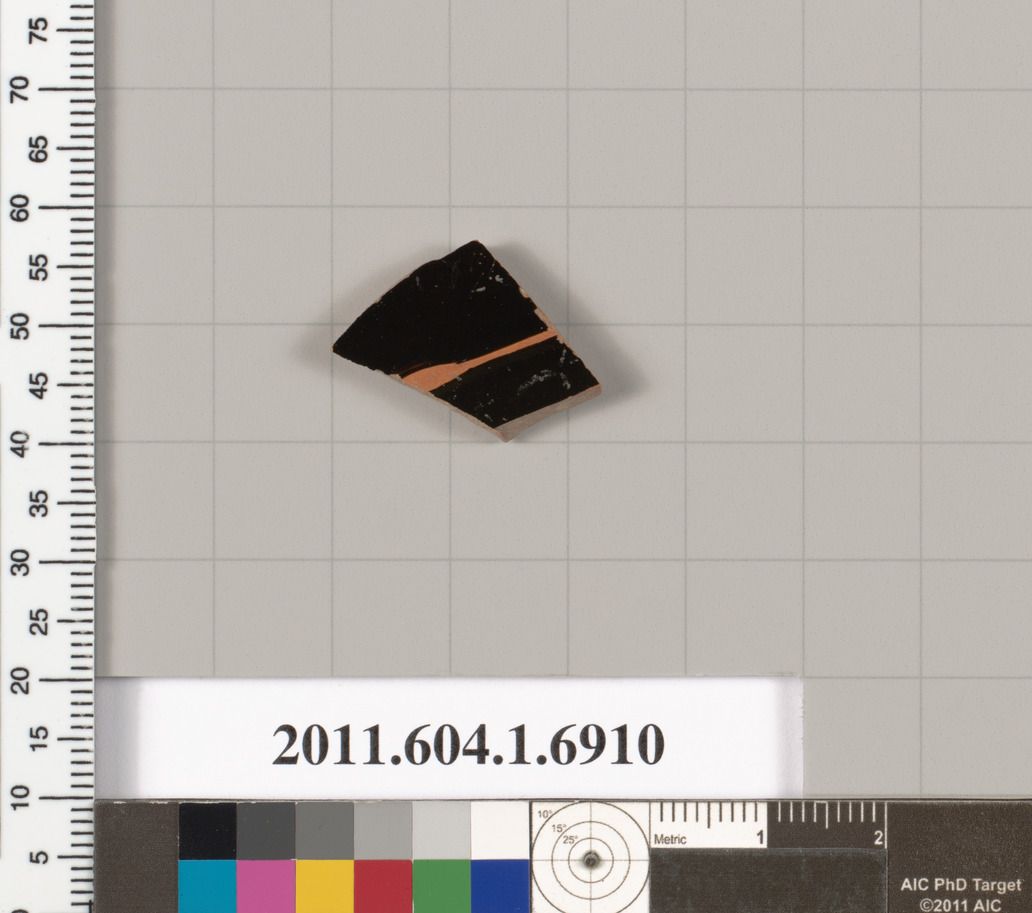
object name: kylix fragment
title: Terracotta fragment of a kylix (drinking cup)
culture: greek, attic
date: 490-470 BCE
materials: terracotta